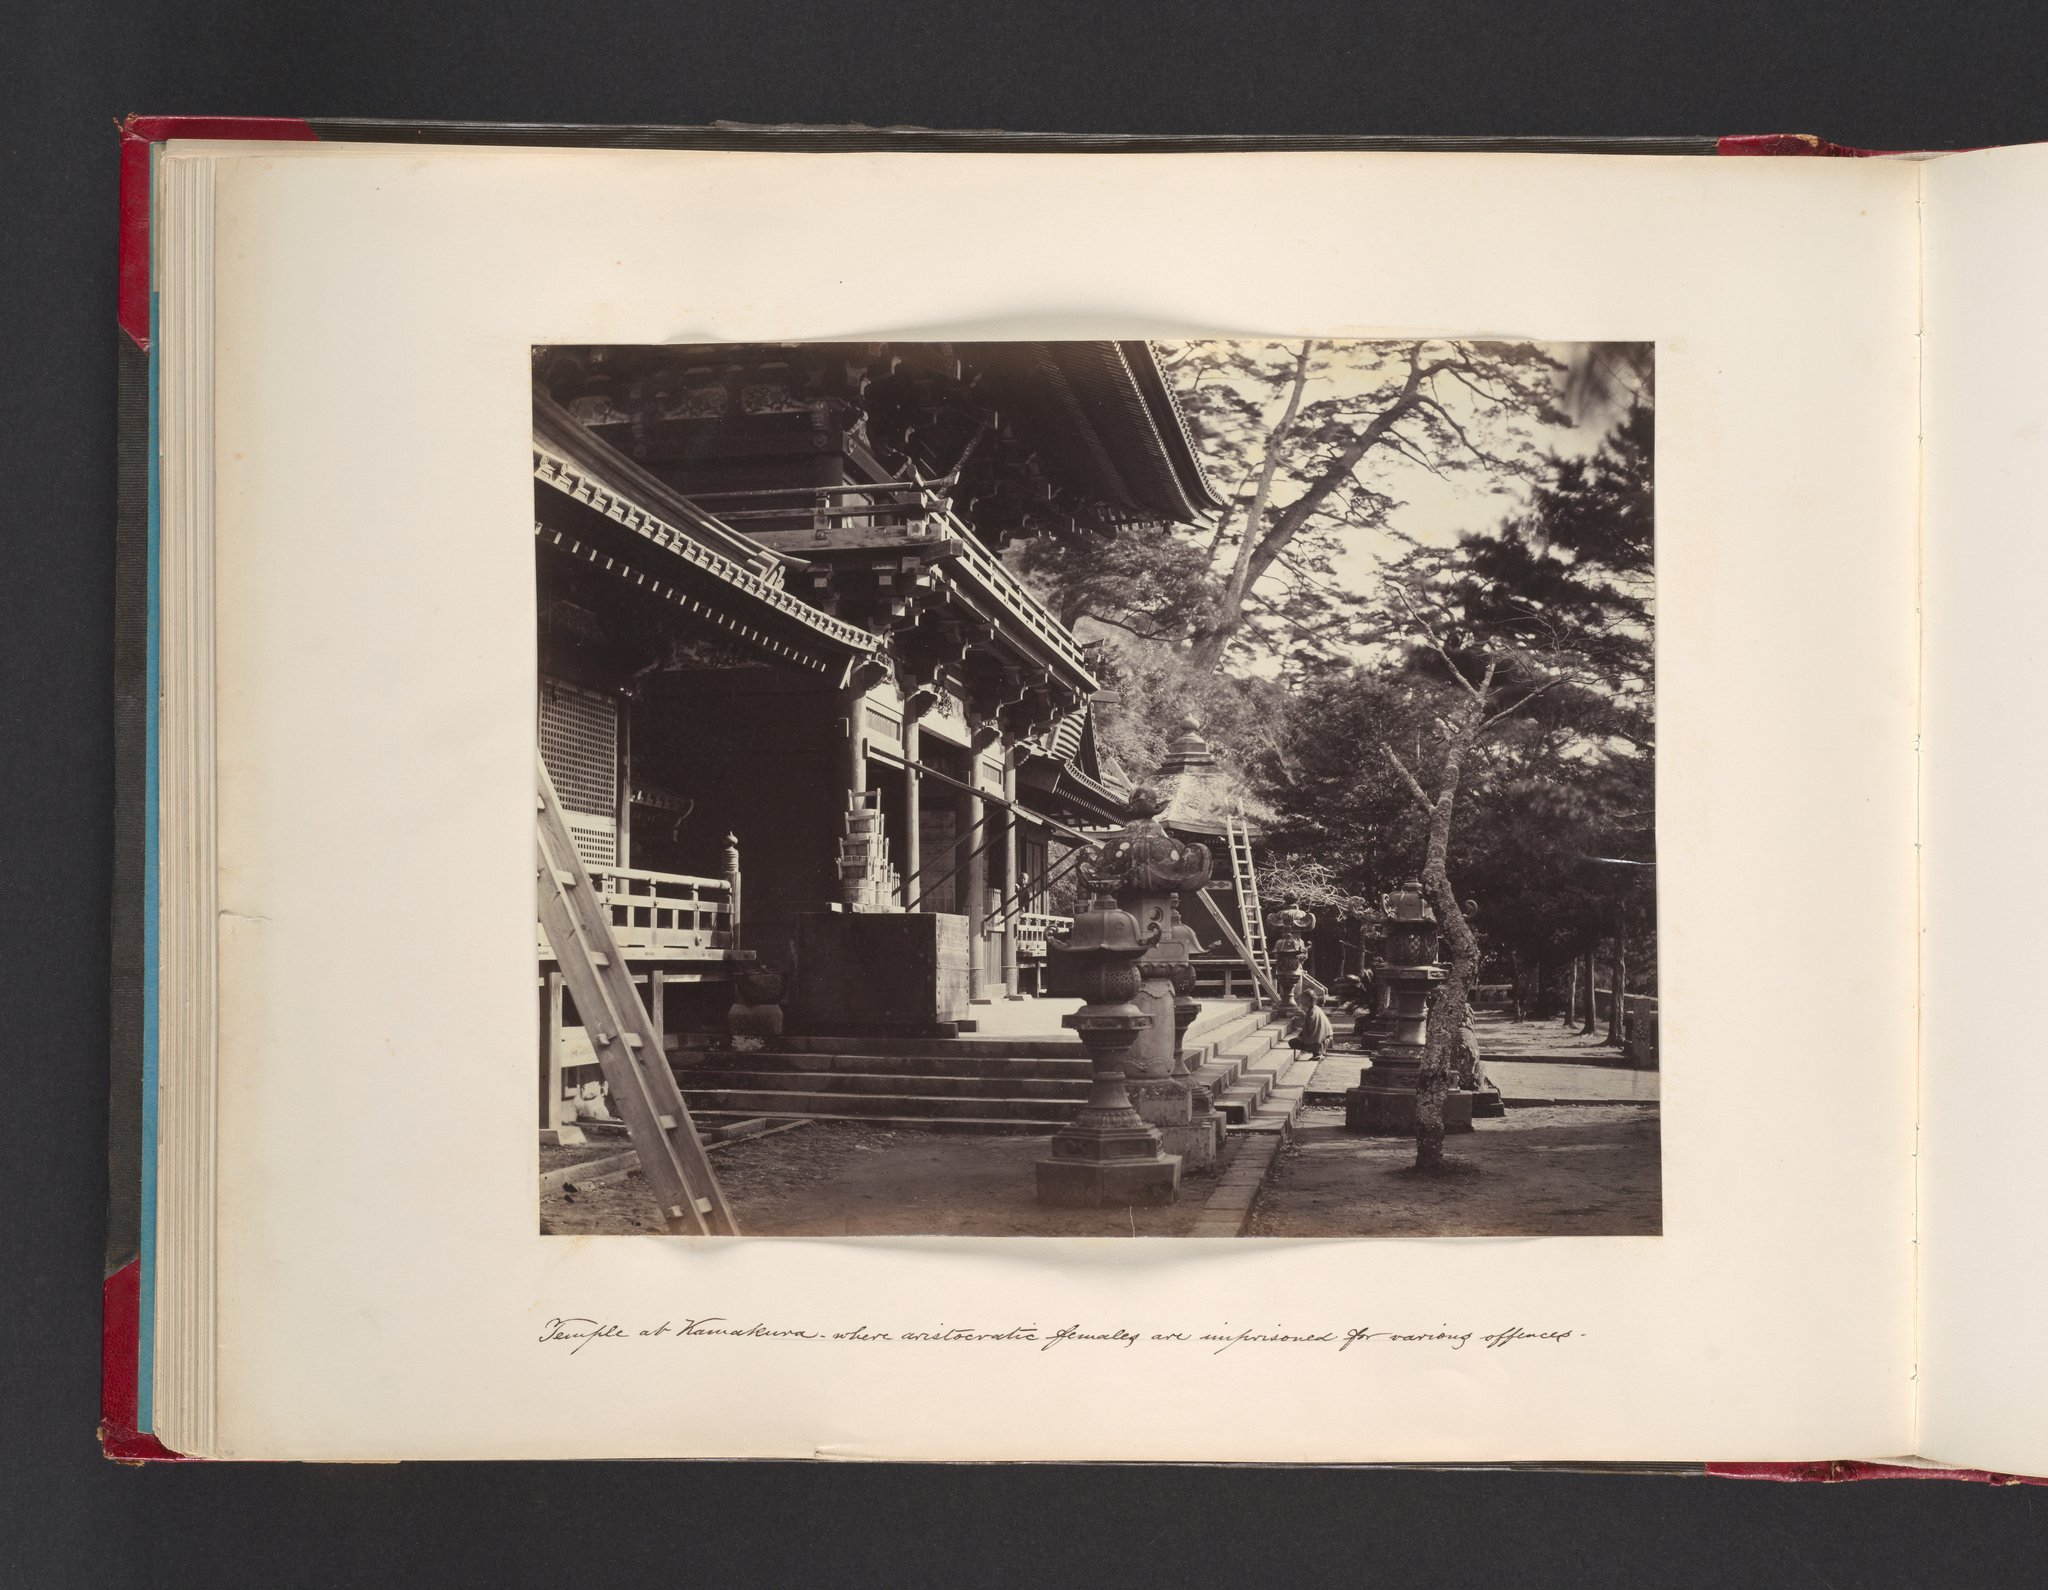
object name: photograph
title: Temple at Kamakura Where Aristocratic Female are Imprisoned for Various Offences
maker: john thomson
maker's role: artist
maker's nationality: british, scottish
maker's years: 1837-1921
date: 1865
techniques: albumen silver print, glass negative